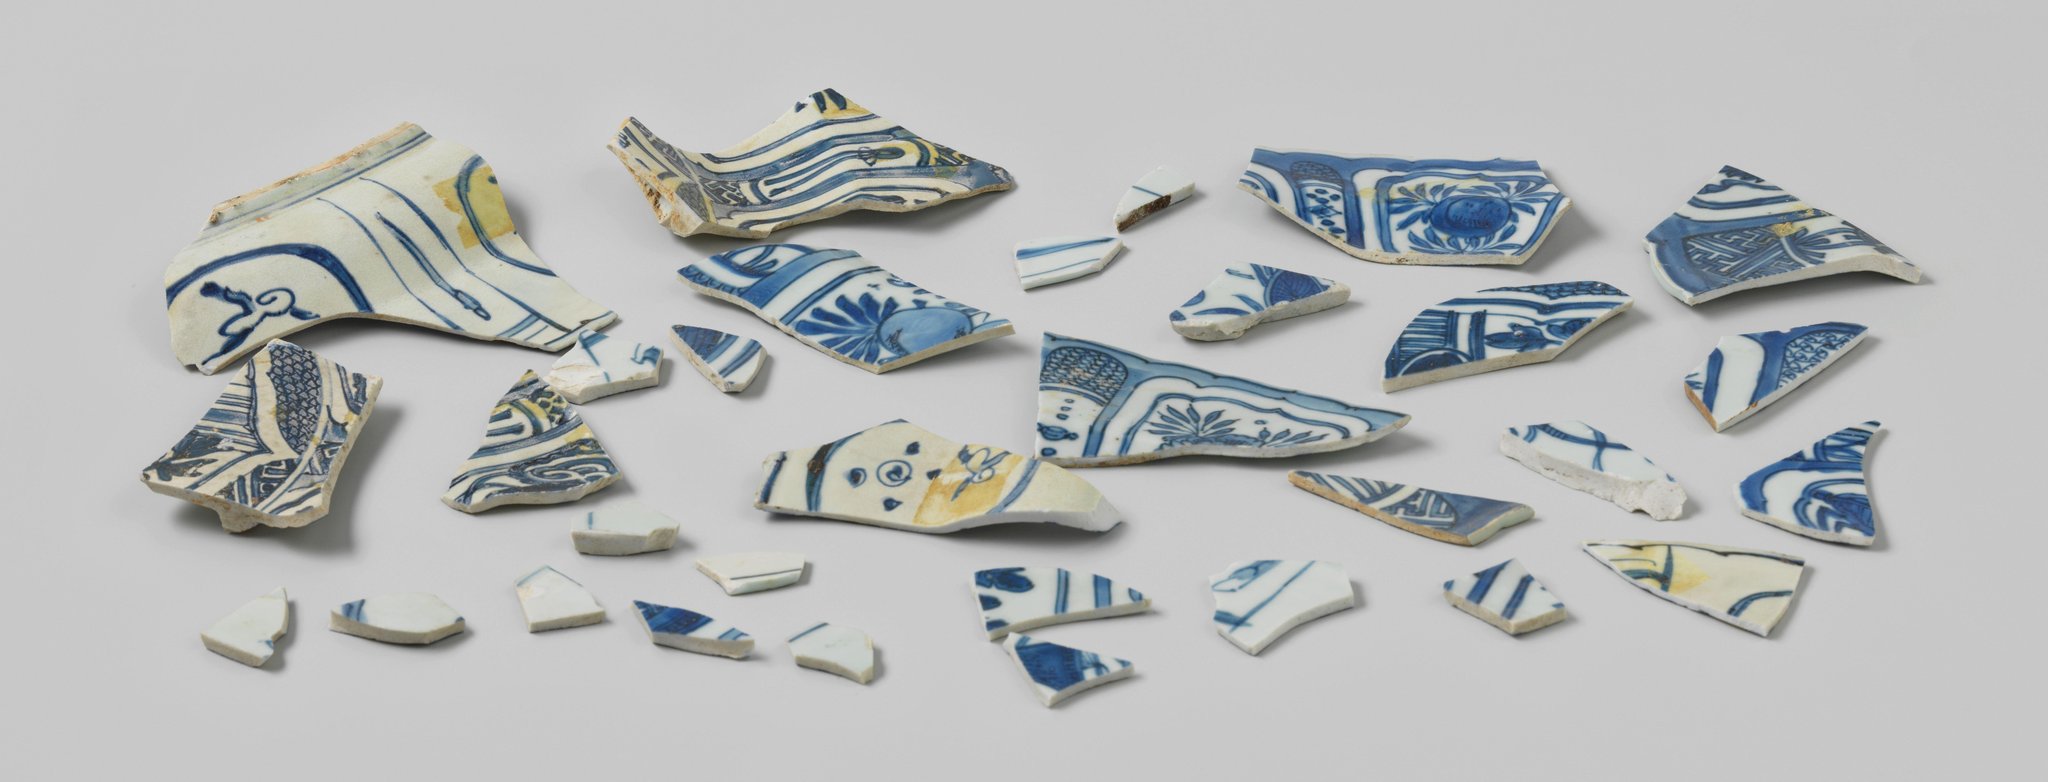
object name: plate dish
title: Scherven van borden uit V.O.C.-schip de 'Witte Leeuw'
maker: Anonymous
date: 1613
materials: bone china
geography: jingdezhen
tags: verenigde oostindische compagnie, sint-helena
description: Scherven van borden uit V.O.C.-schip de 'Witte Leeuw'.